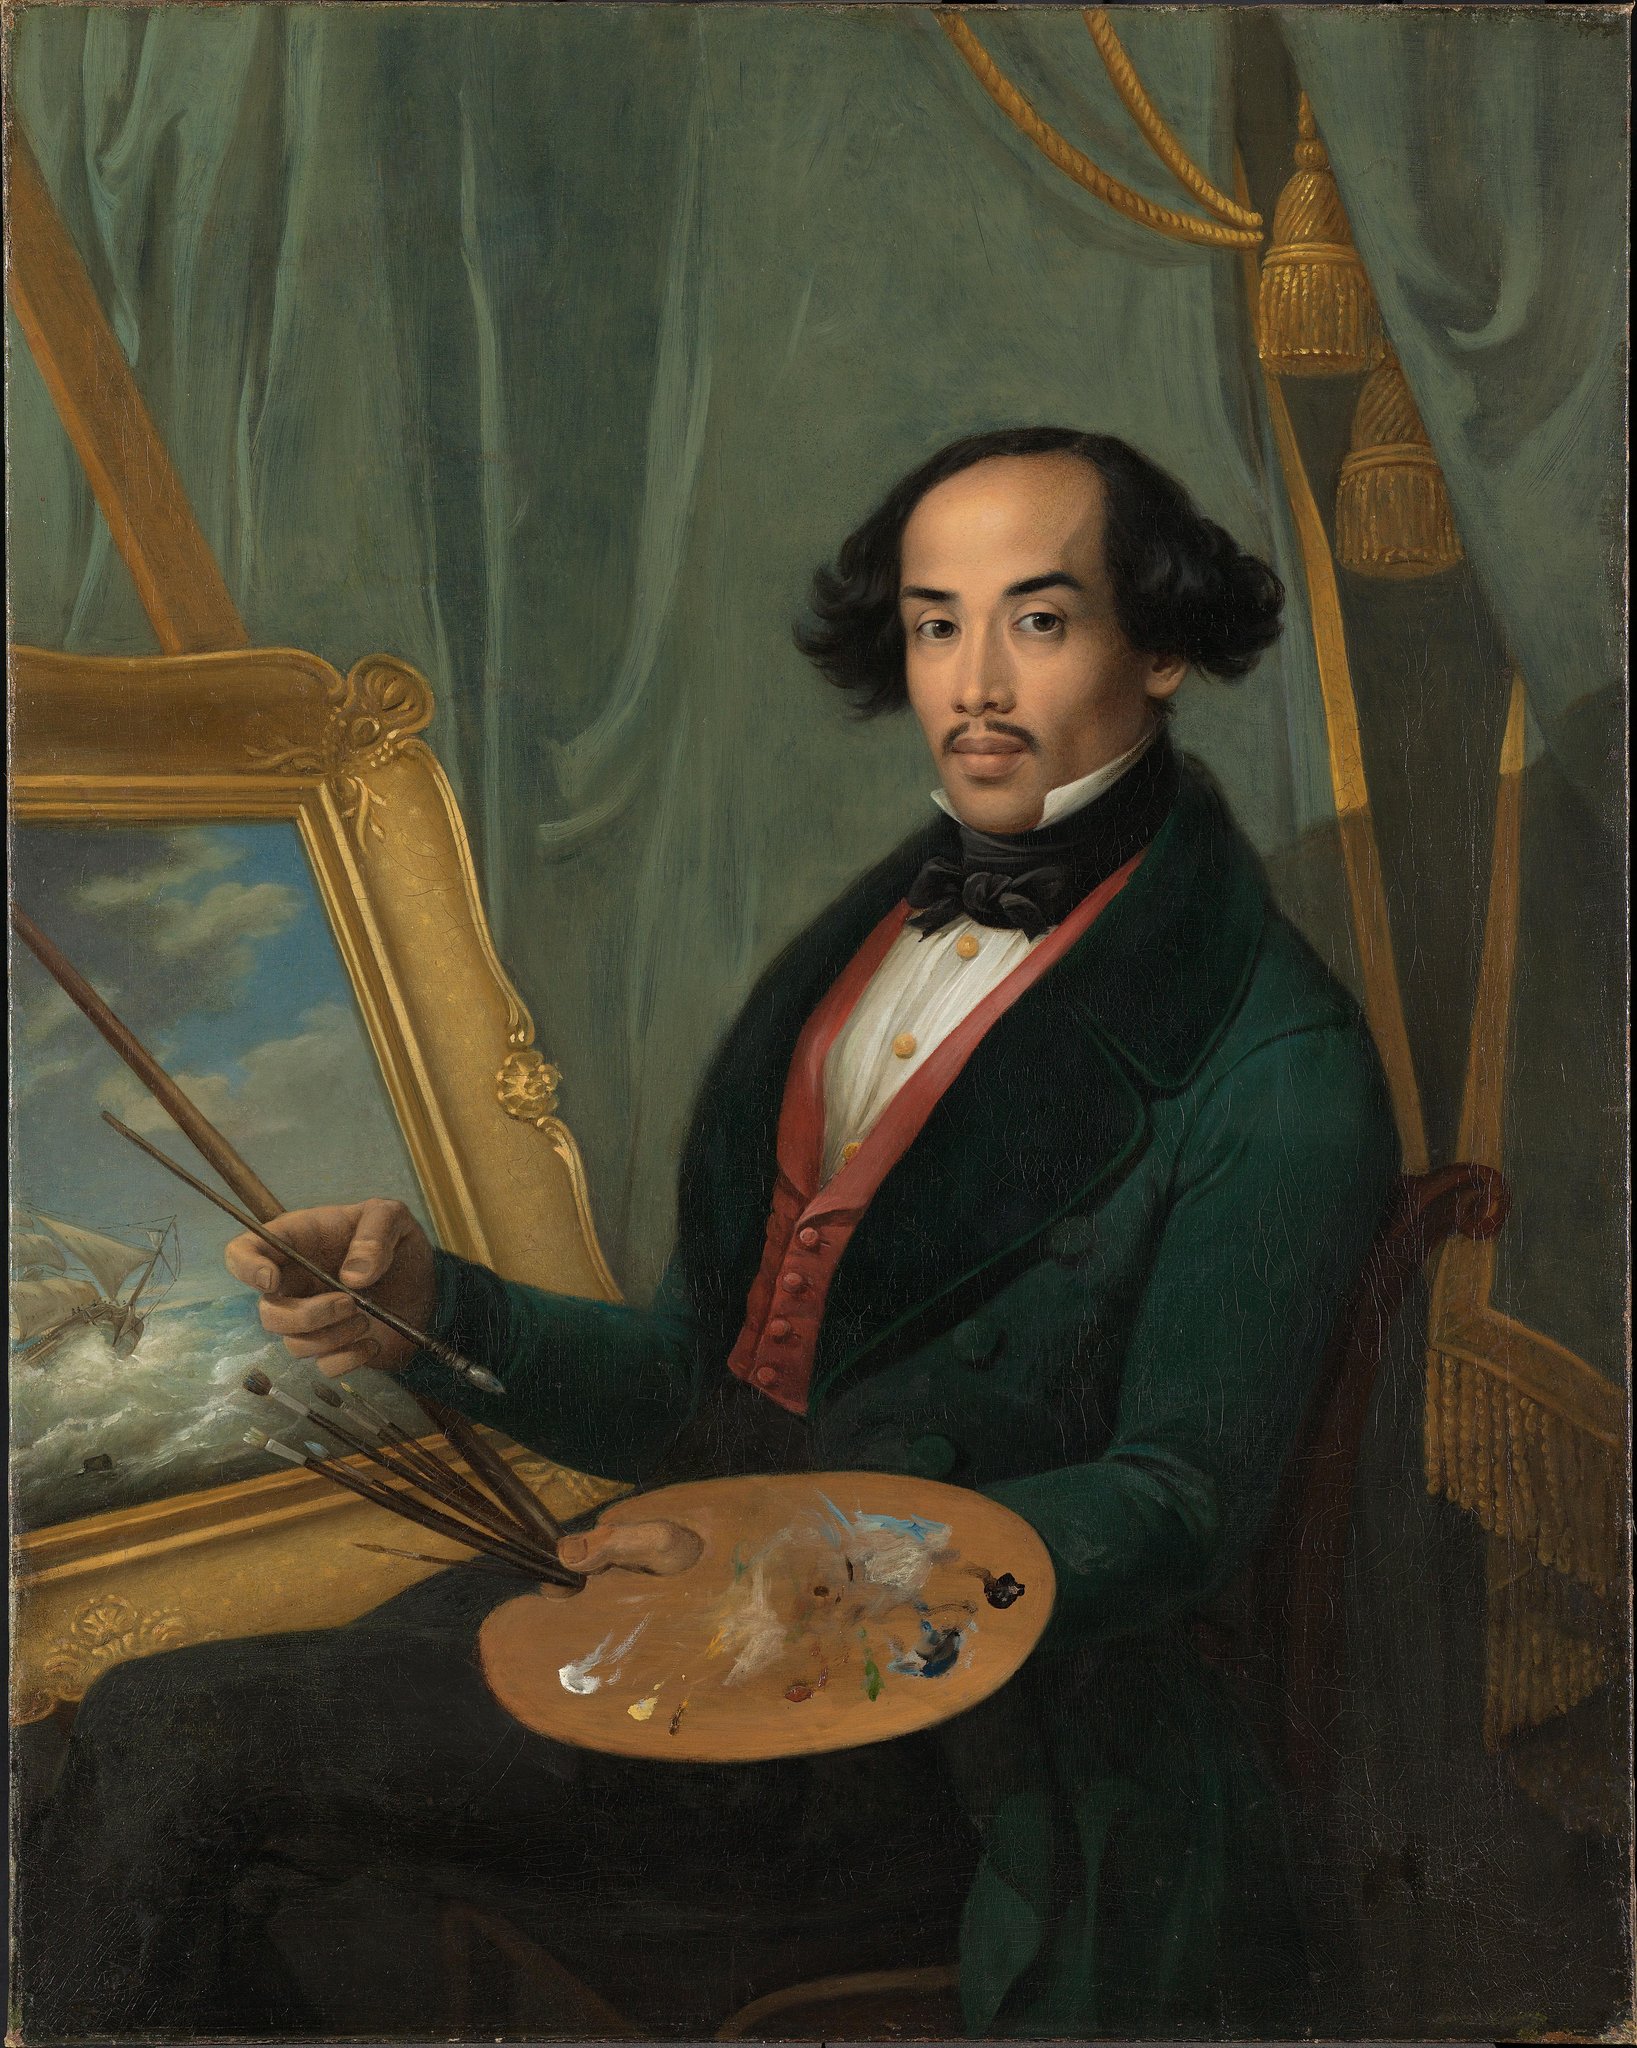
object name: painting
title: Portrait of Raden Syarif Bustaman Saleh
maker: friedrich carl albert schreuel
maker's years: 1773-1853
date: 1840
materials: canvas, oil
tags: painter, draughtsman, raden sarief bastaman saleh, portrait, self-portrait of painter, sea (seascape), painter at work, in his studio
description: Raden Saleh, scion of a Javanese regent family, came to the Netherlands in 1829 to study painting. Here we still see him as a European dandy before a Western seascape. However, he soon specialized in oriental scenes, and began dressing as a Javanese prince. Back on Java (1851), Raden Saleh built a small neo-Gothic palace, where he received the European elite. And so he constantly shifted between his Javanese and his European identity.